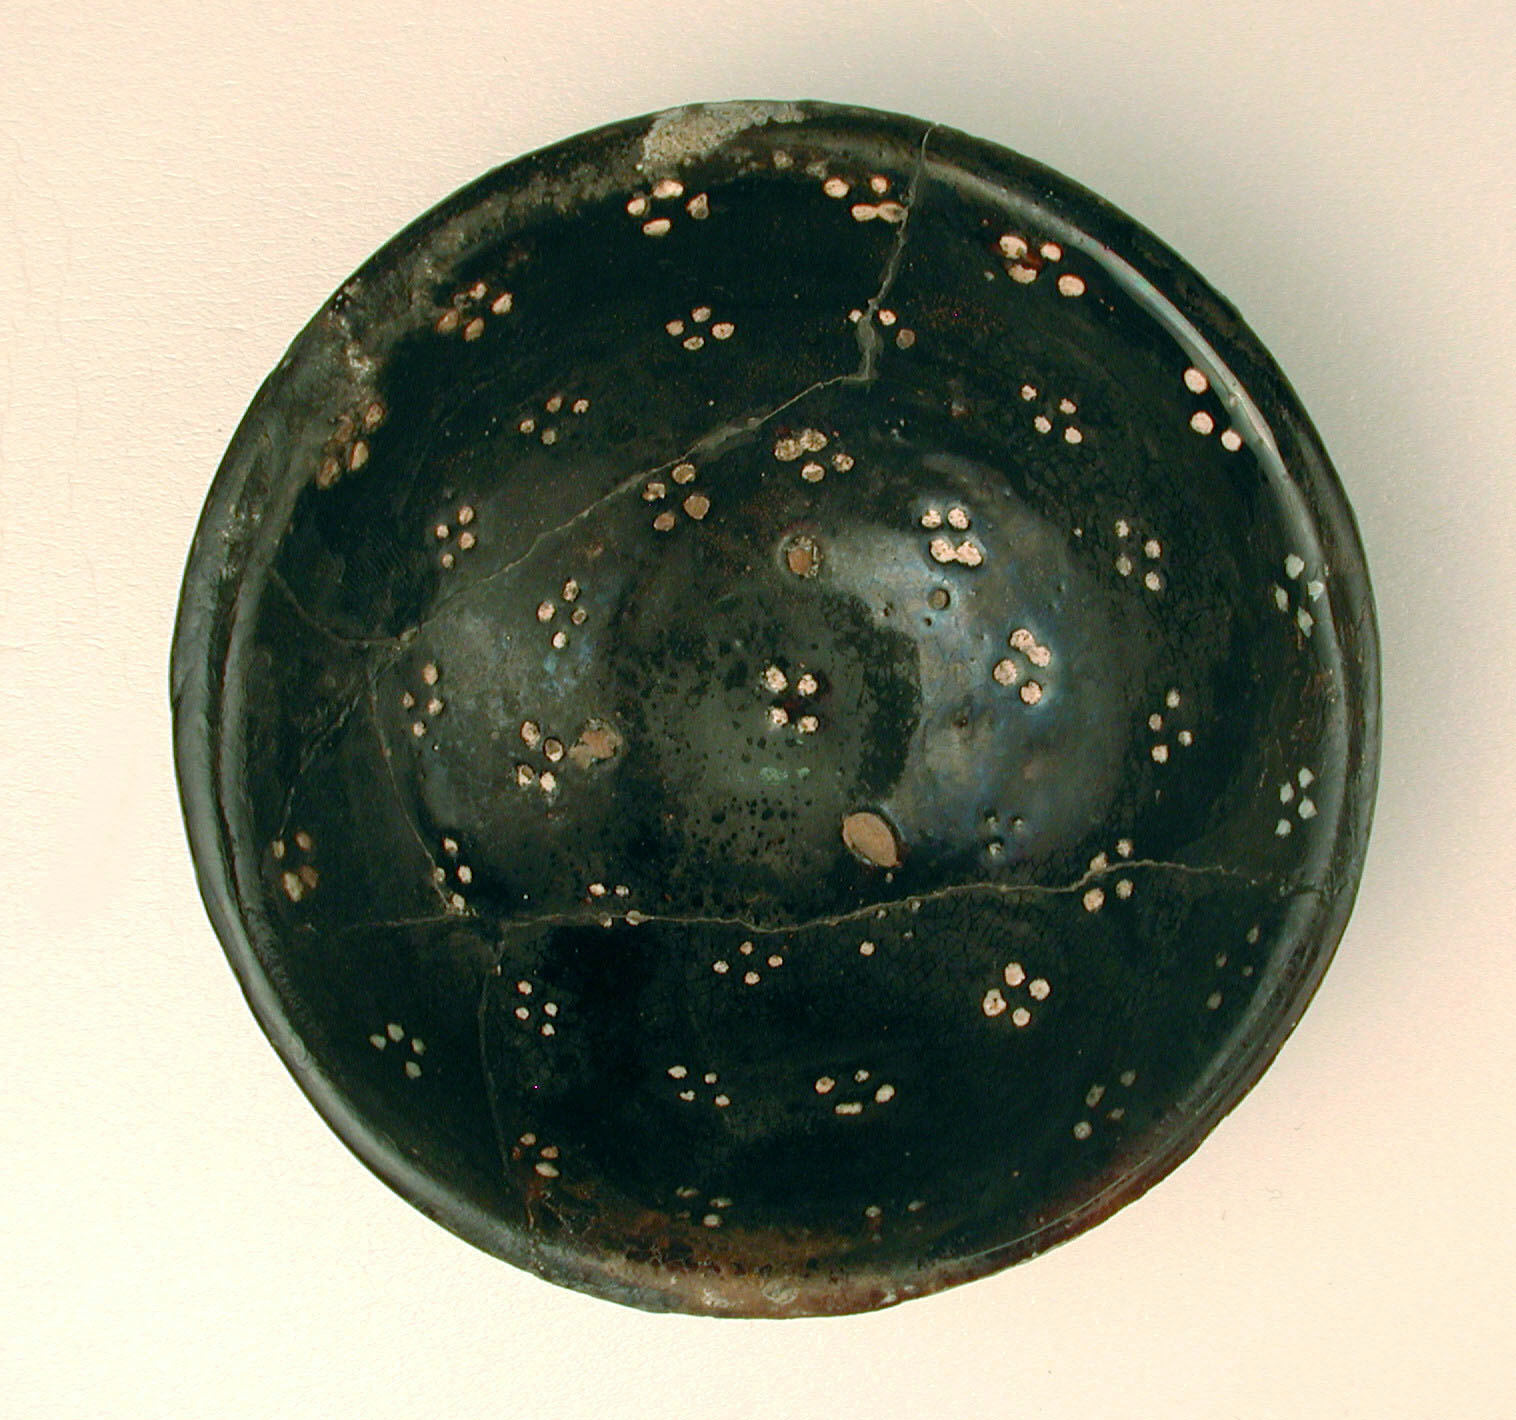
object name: bowl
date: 901-1000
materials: earthenware, glaze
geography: uzbekistan